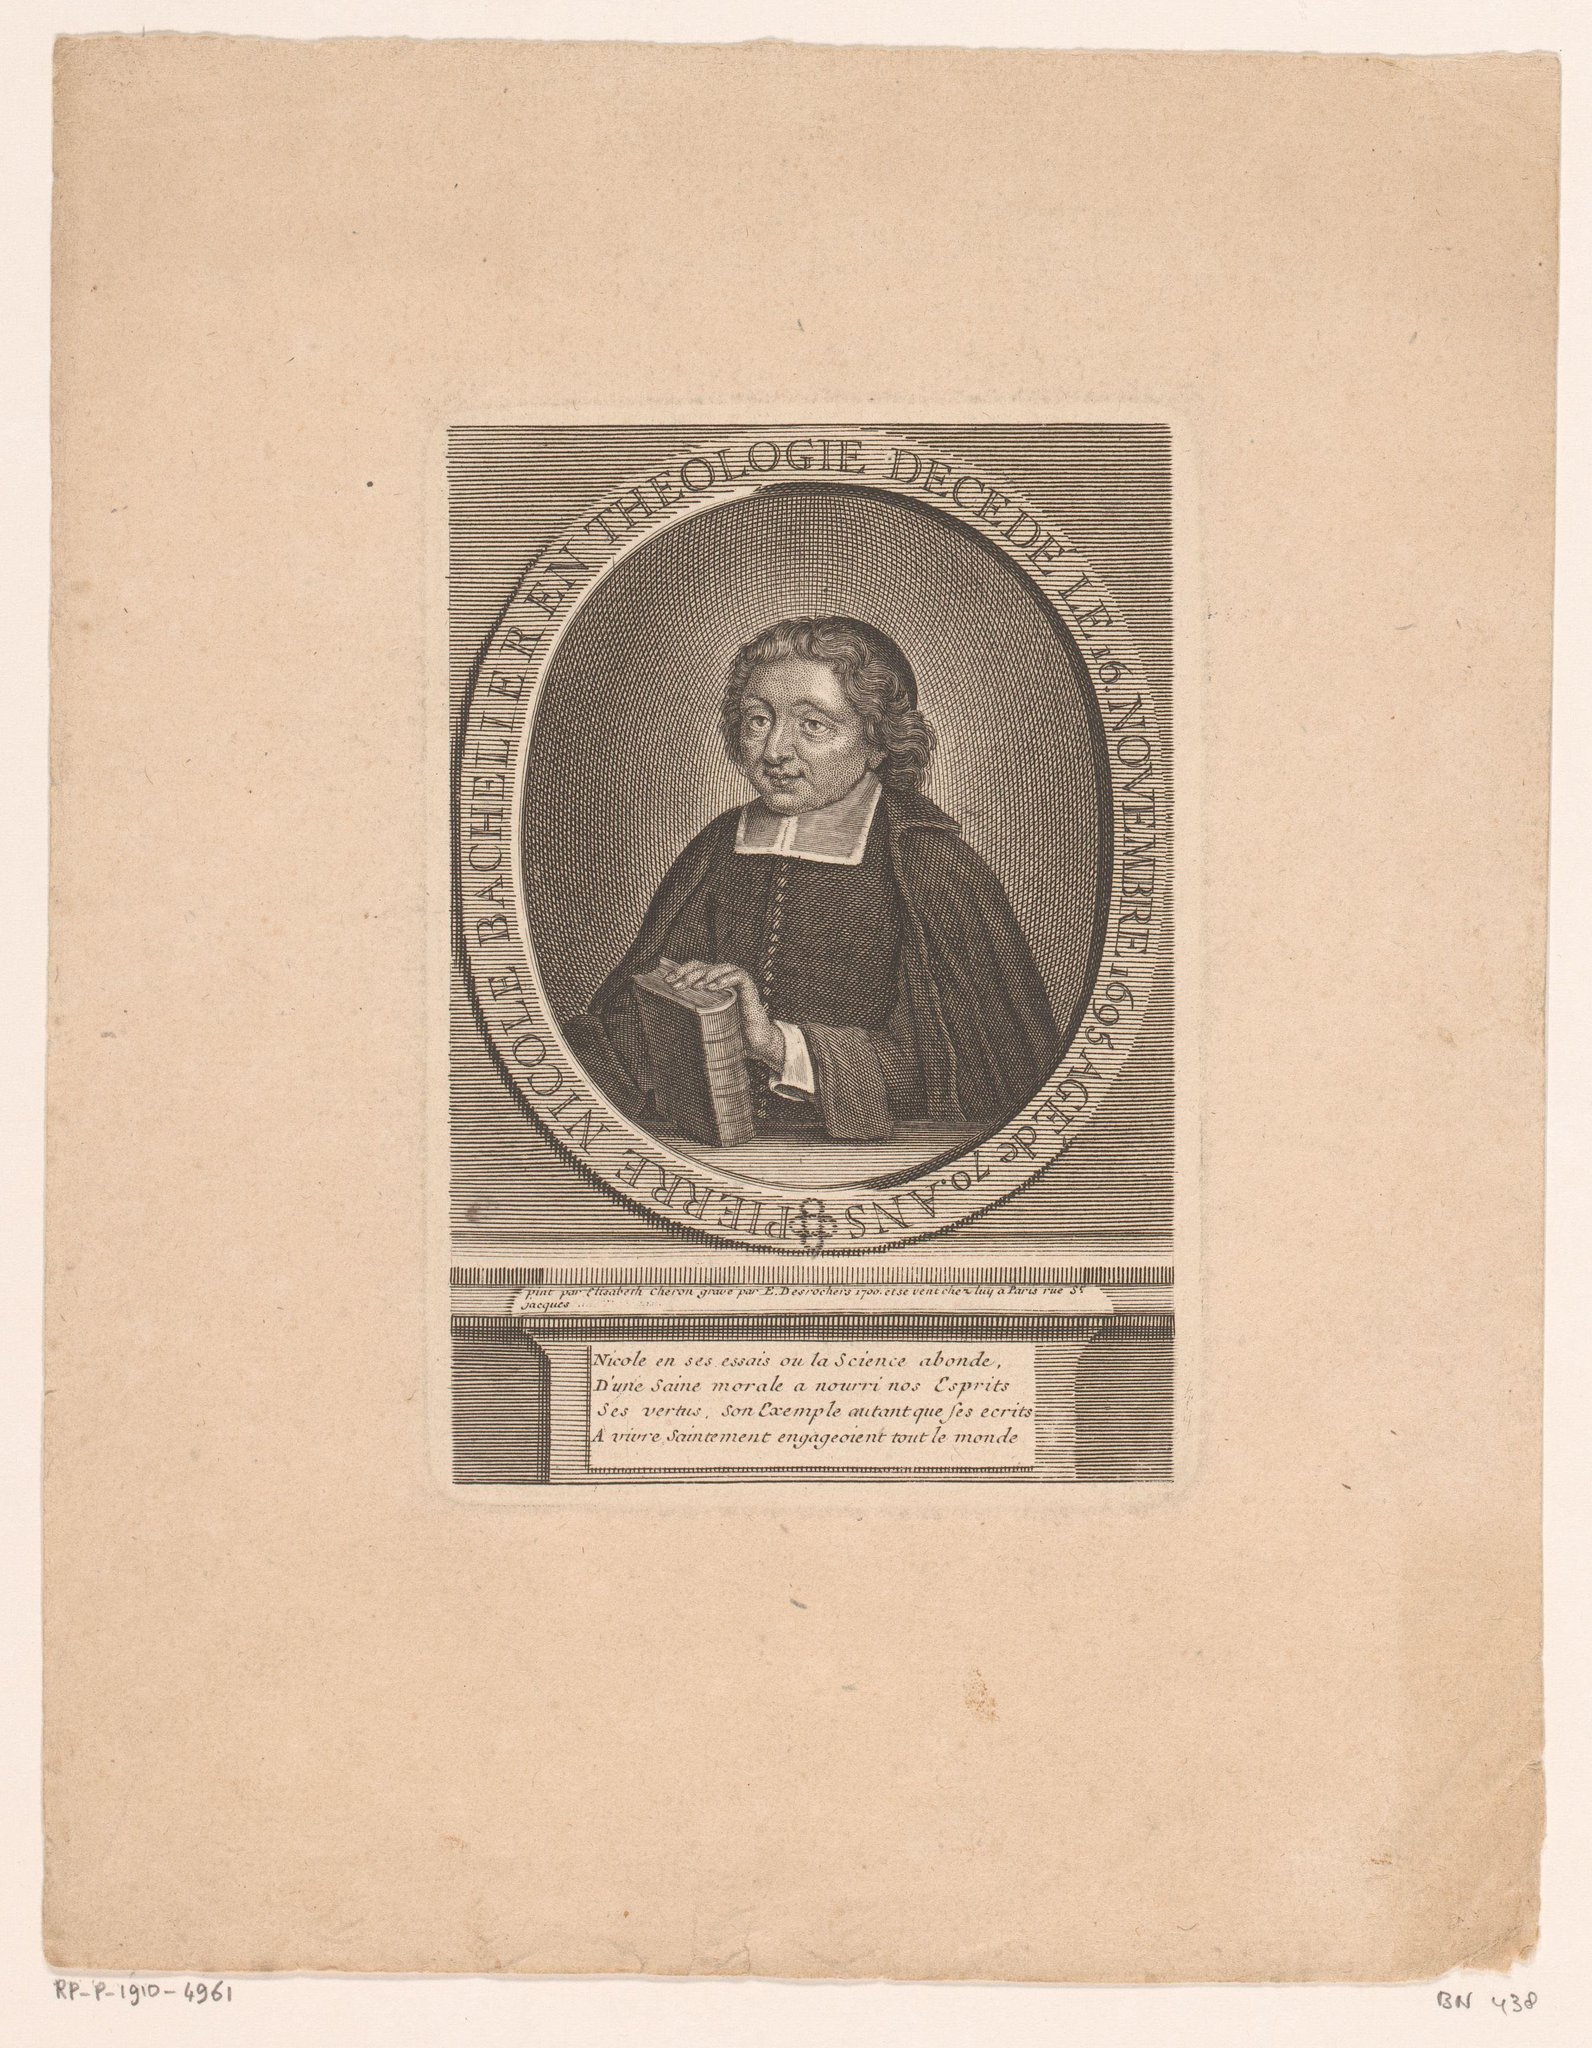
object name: print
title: Recueil de portraits (...)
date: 1700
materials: paper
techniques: engraving, etching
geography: paris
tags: paris, theologian, historical persons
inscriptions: collector's mark: Lugt 2228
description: Behoort waarschijnlijk tot een serie portretten, grotendeels door Etienne Desrochers, getiteld: 'Recueil de portraits de personnes qui se sont distinguées tant dans les Armes que dans Belles-Lettres et les Arts, comme aussi la famille royale de France et autres cours étrangères'. De serie werd initieel uitgegeven door Desrochers en aangekondigd in 'Mercure' in mei 1726, p. 985. Echter was Desrochers reeds enkele jaren eerder begonnen met het uitgeven van de serie. Na de dood van Desrochers werd de serie voortgezet door Gilles Edme Petit. Een latere staat werd uitgegeven door Jean François Daumont in Parijs.